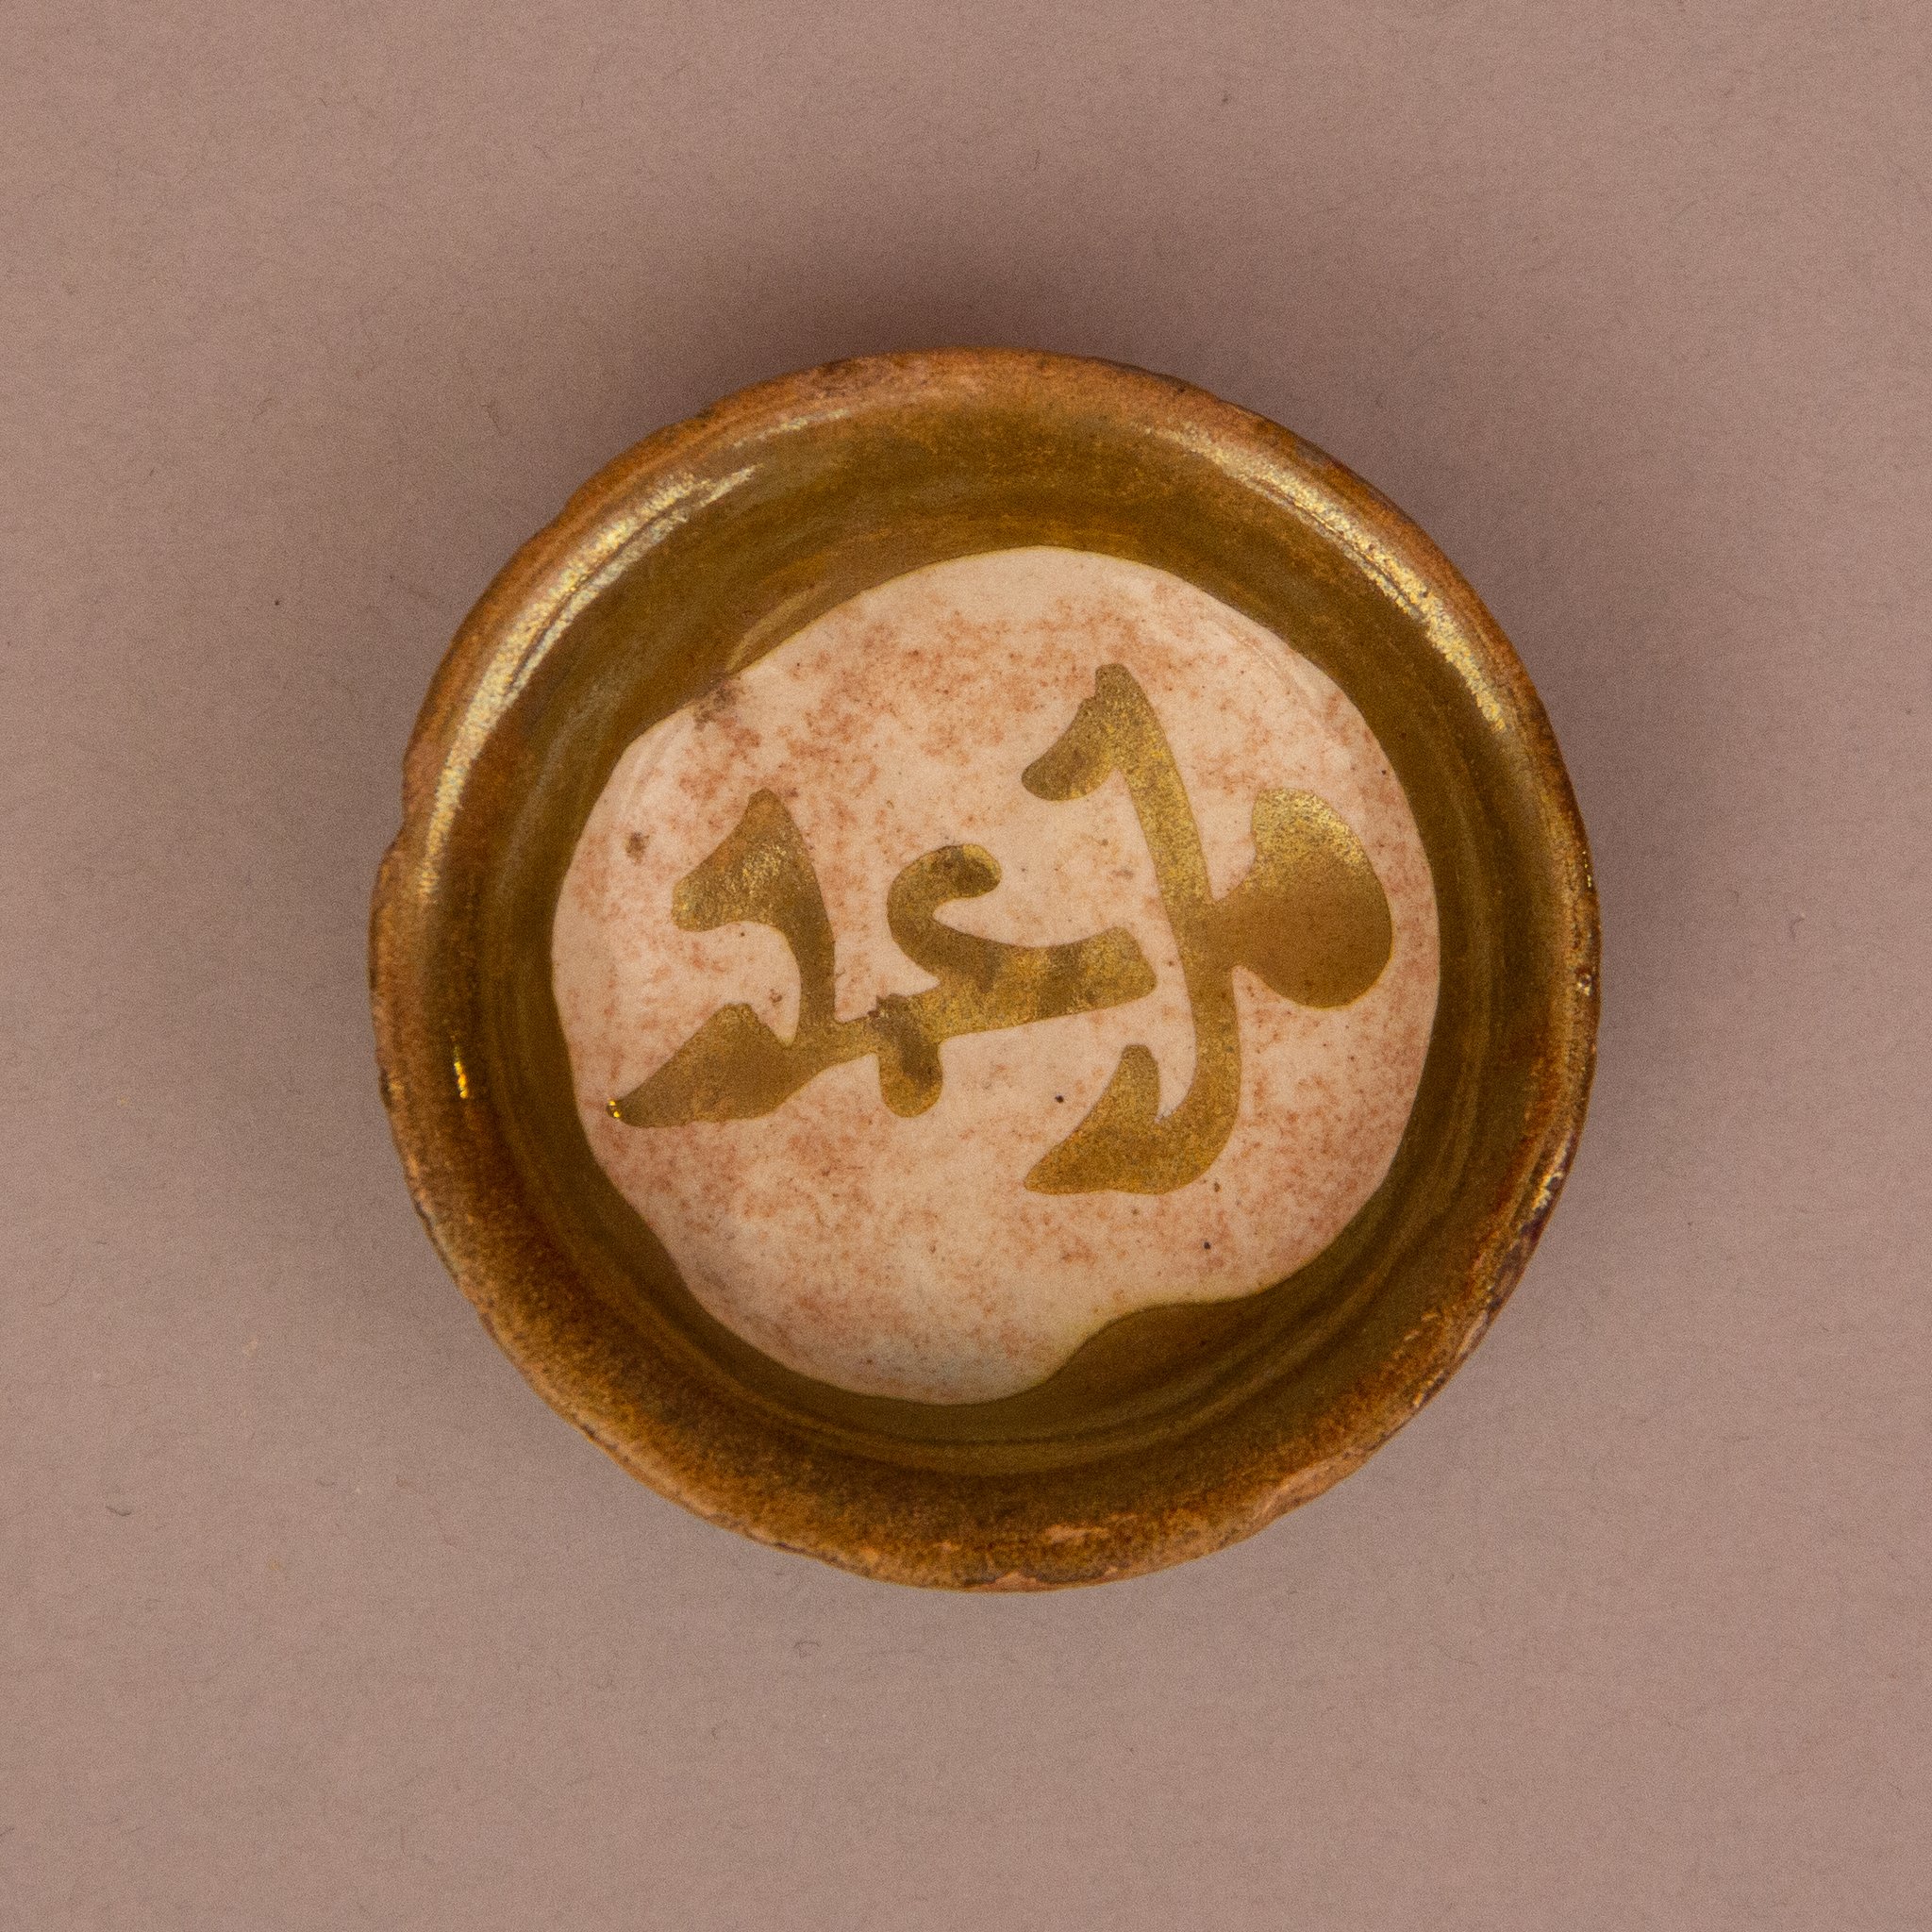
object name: dish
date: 901-1000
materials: earthenware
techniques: luster painting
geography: iraq